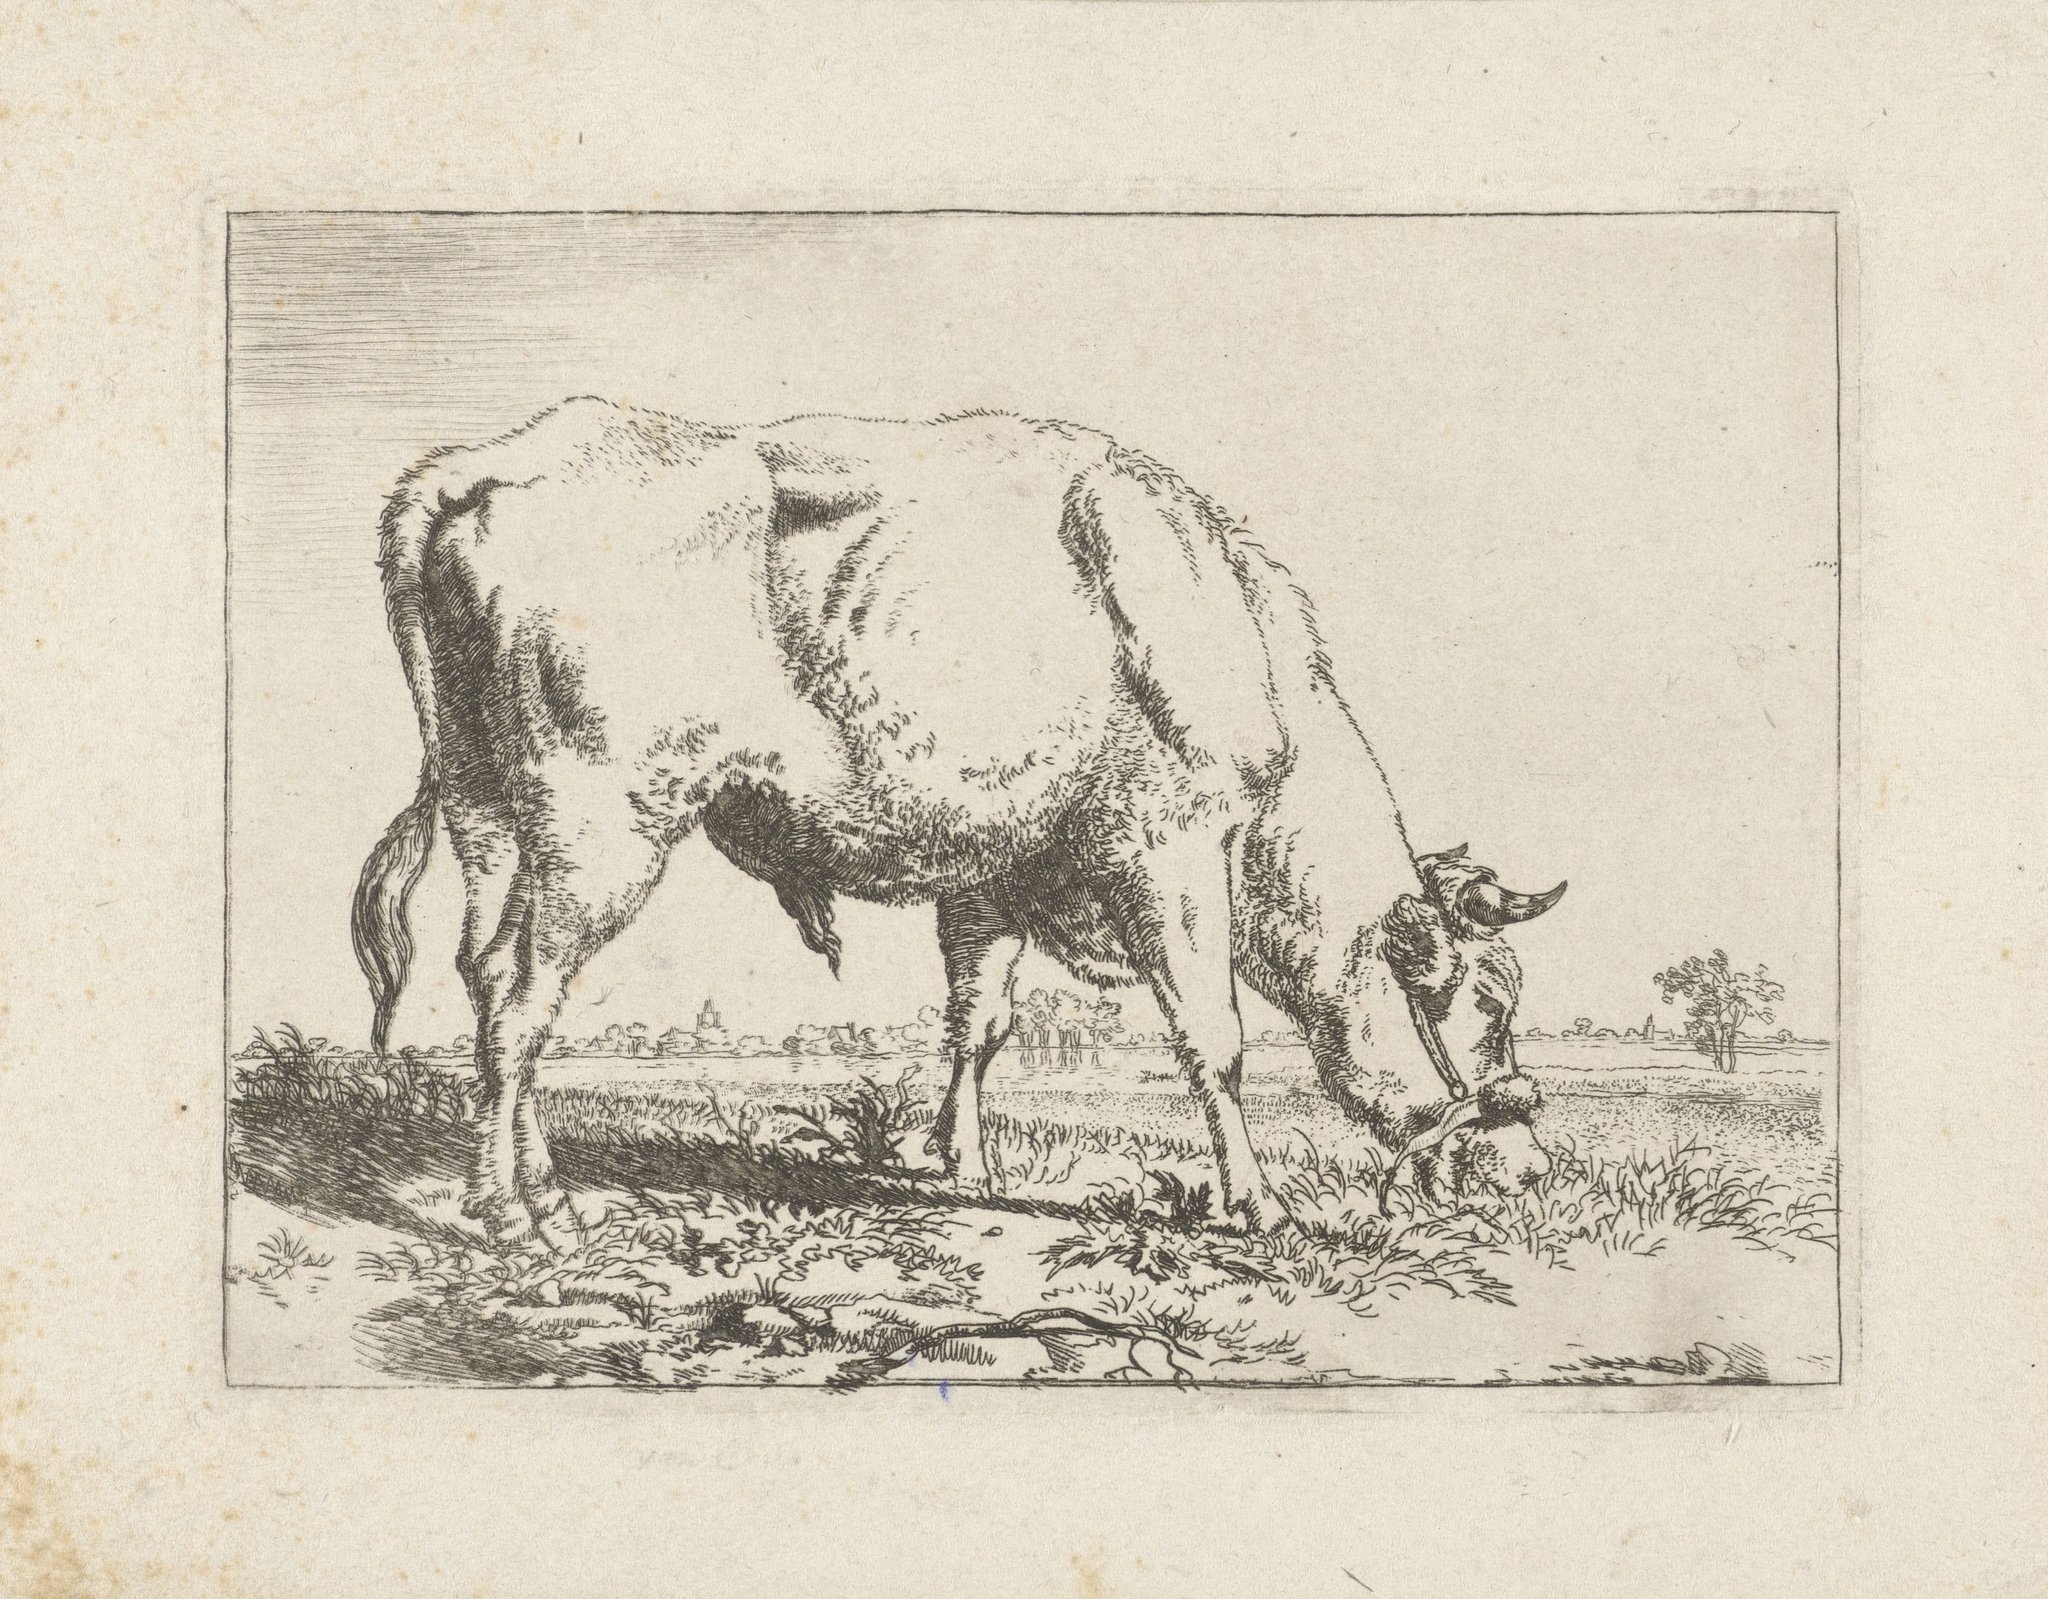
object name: print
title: Grazende stier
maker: pieter gerardus van os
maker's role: draughtsman, painter, print maker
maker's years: 1776-1839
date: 1798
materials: paper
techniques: etching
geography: netherlands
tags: bull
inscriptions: collector's mark: Lugt 2166